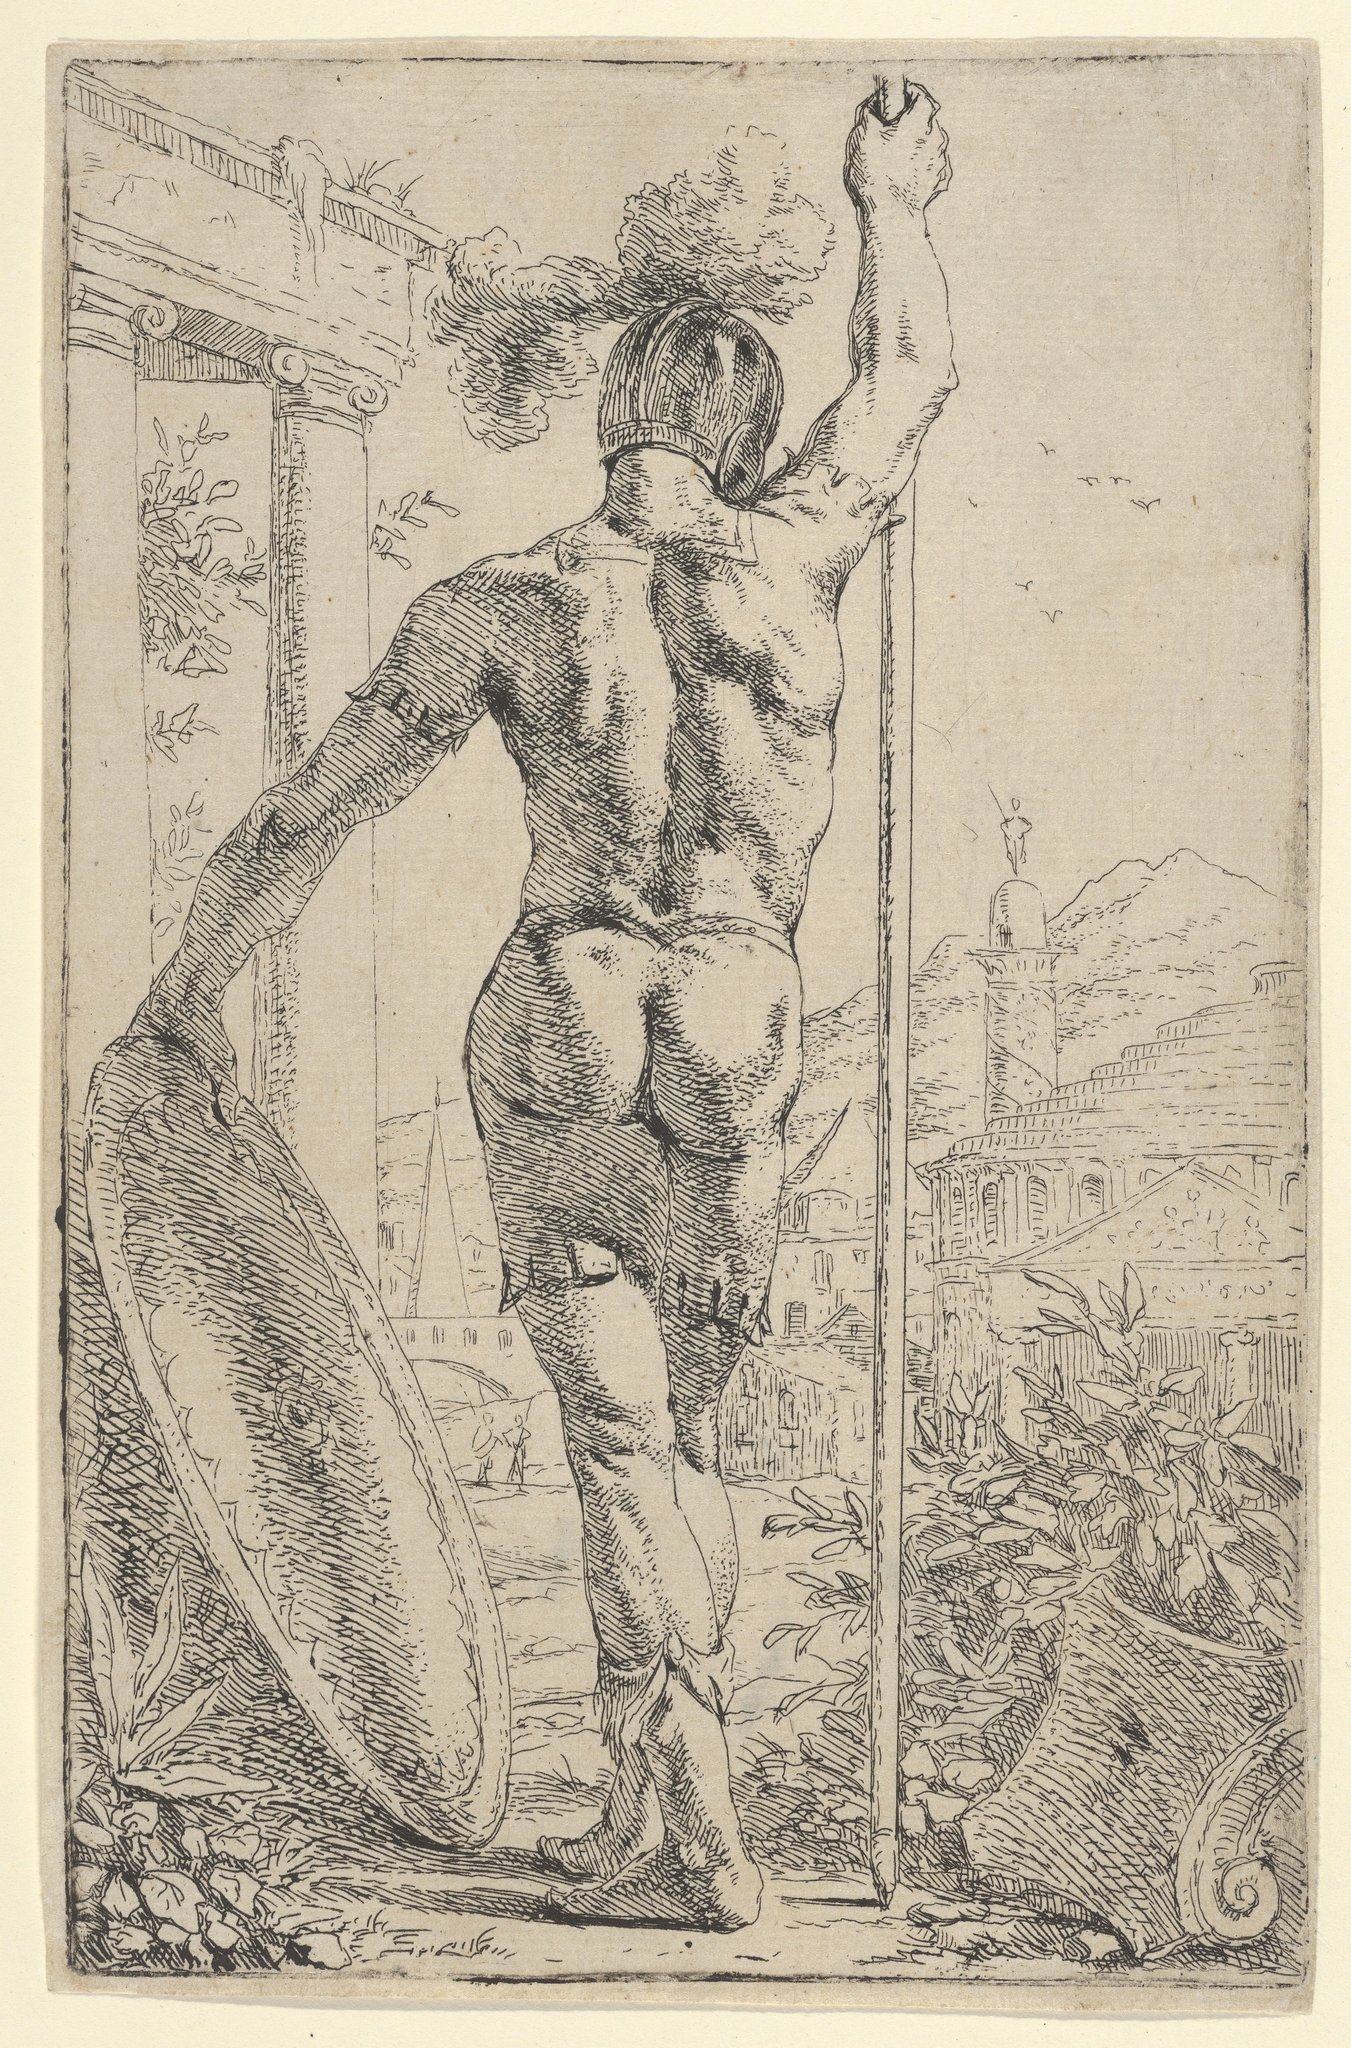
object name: print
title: A Roman Warrior with Shield and Spear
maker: leendert van der cooghen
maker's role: artist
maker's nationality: netherlandish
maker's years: 1610-1681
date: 1666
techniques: etching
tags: soldiers,men